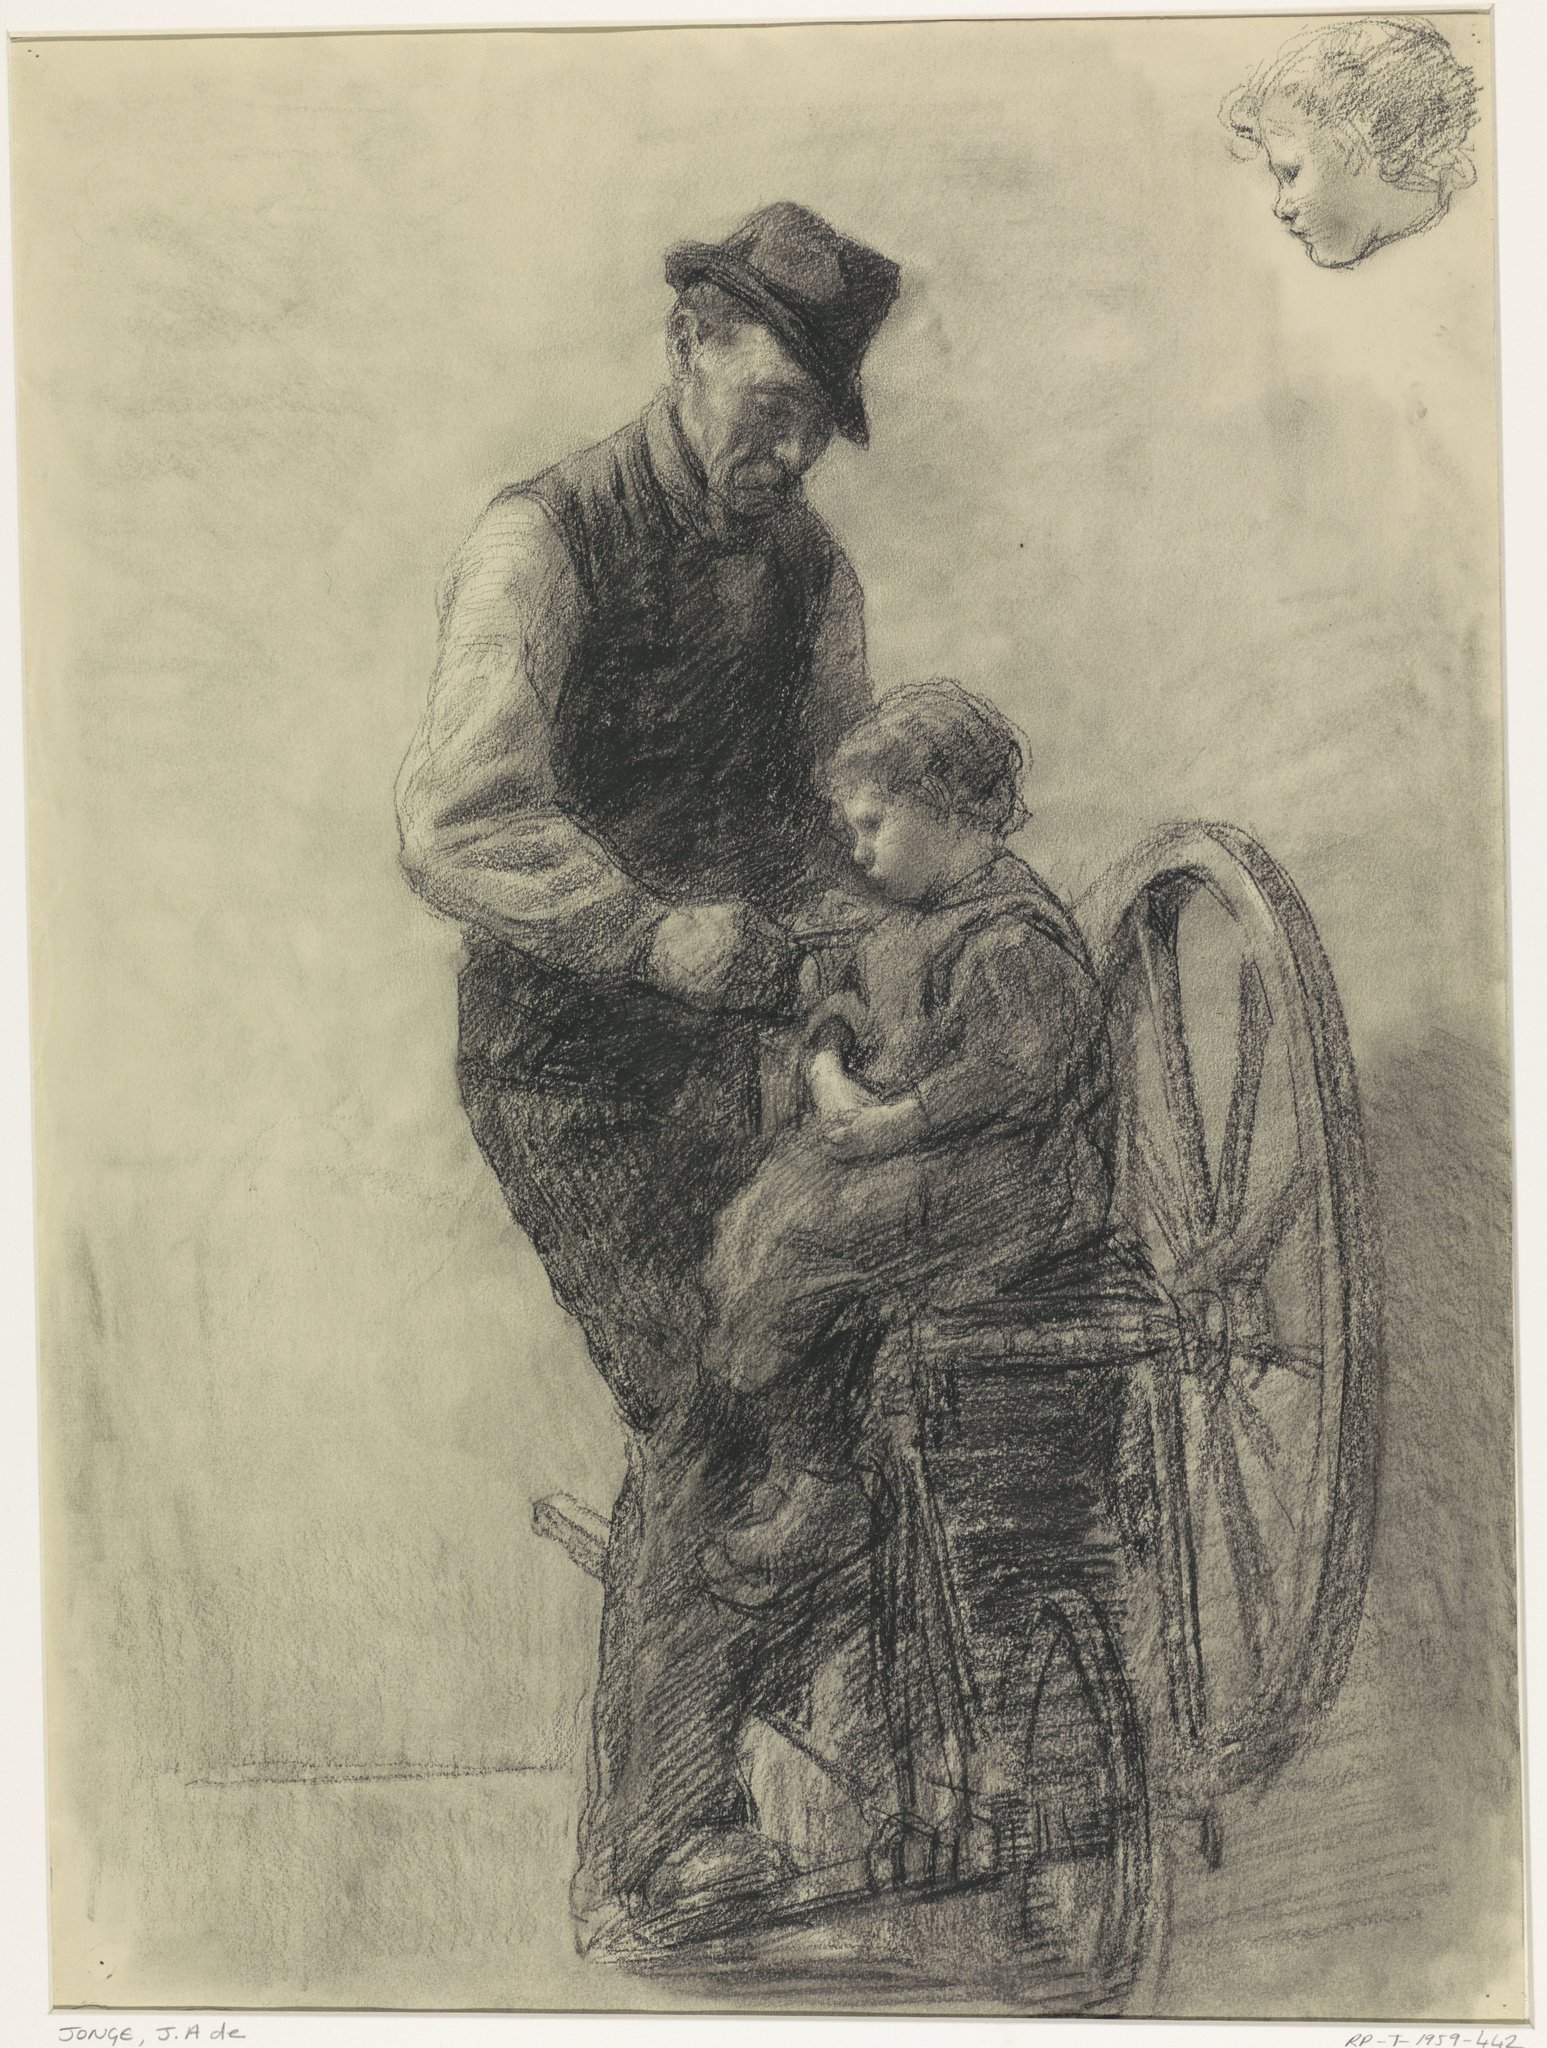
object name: drawing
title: Studie van een scharensliep aan het werk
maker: johan antonie de jonge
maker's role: draughtsman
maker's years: 1864-1927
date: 1874-1927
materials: chalk, paper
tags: sharpening, grinding (industrial processes), handicrafts ~ maintenance and repair, girl (child between toddler and youth)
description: Studie van een scharensliep aan het werk, met een klein meisje op zijn karretje gezeten.